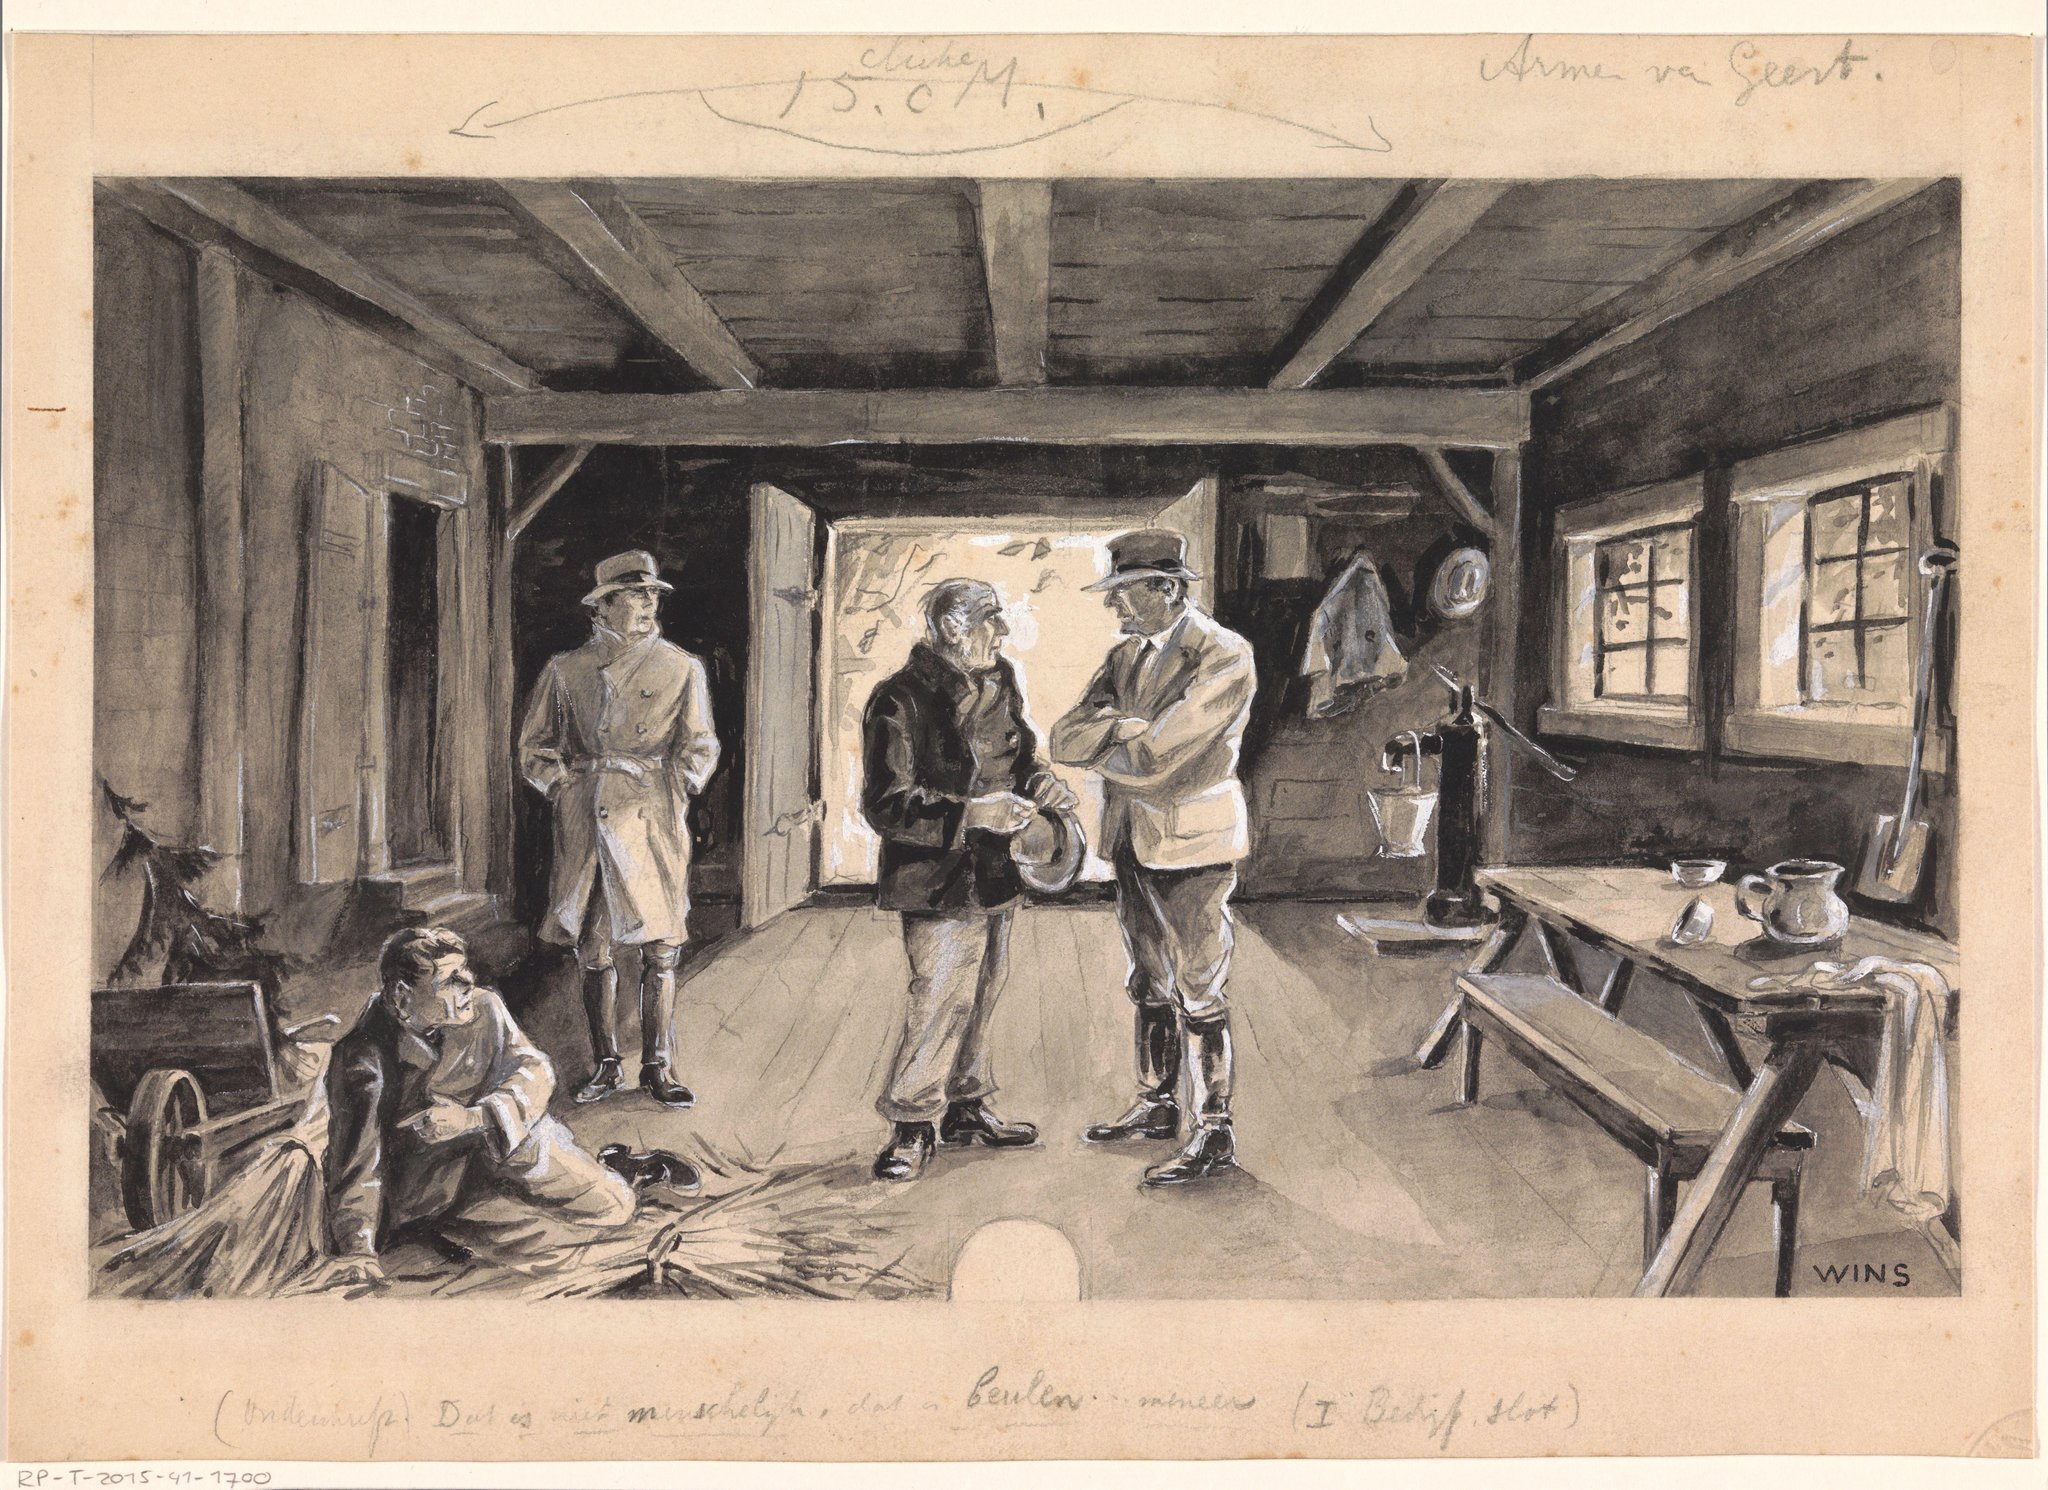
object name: drawing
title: Mannen converseren in een schuur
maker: jos wins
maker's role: draughtsman, print maker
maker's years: 1881-1940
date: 1928-1931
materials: paint, ink, paper, pencil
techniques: brush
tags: barn, sheaf, conversation, dialogue; conversation piece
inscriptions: :, collector's mark: Lugt 2228, annotation: ‘Terug aan H v Wermeskerken/ Emmastr 61/ Haag’, signature: ‘WINS’, annotation: ‘Armen van Geest./ (onderschrift) Dat is niet menschelijk, dat is beulen ... meneer (I Bedrijf, slot)’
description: Twee mannen met hoge hoeden staan in een schuur. Eén van hen praat met een oudere man die zijn hoed in de hand heeft. Op de grond zit een man tussen de korenschoven. Hij wijst in de verte. In de ruimte staan een tafel met bank en een waterput.